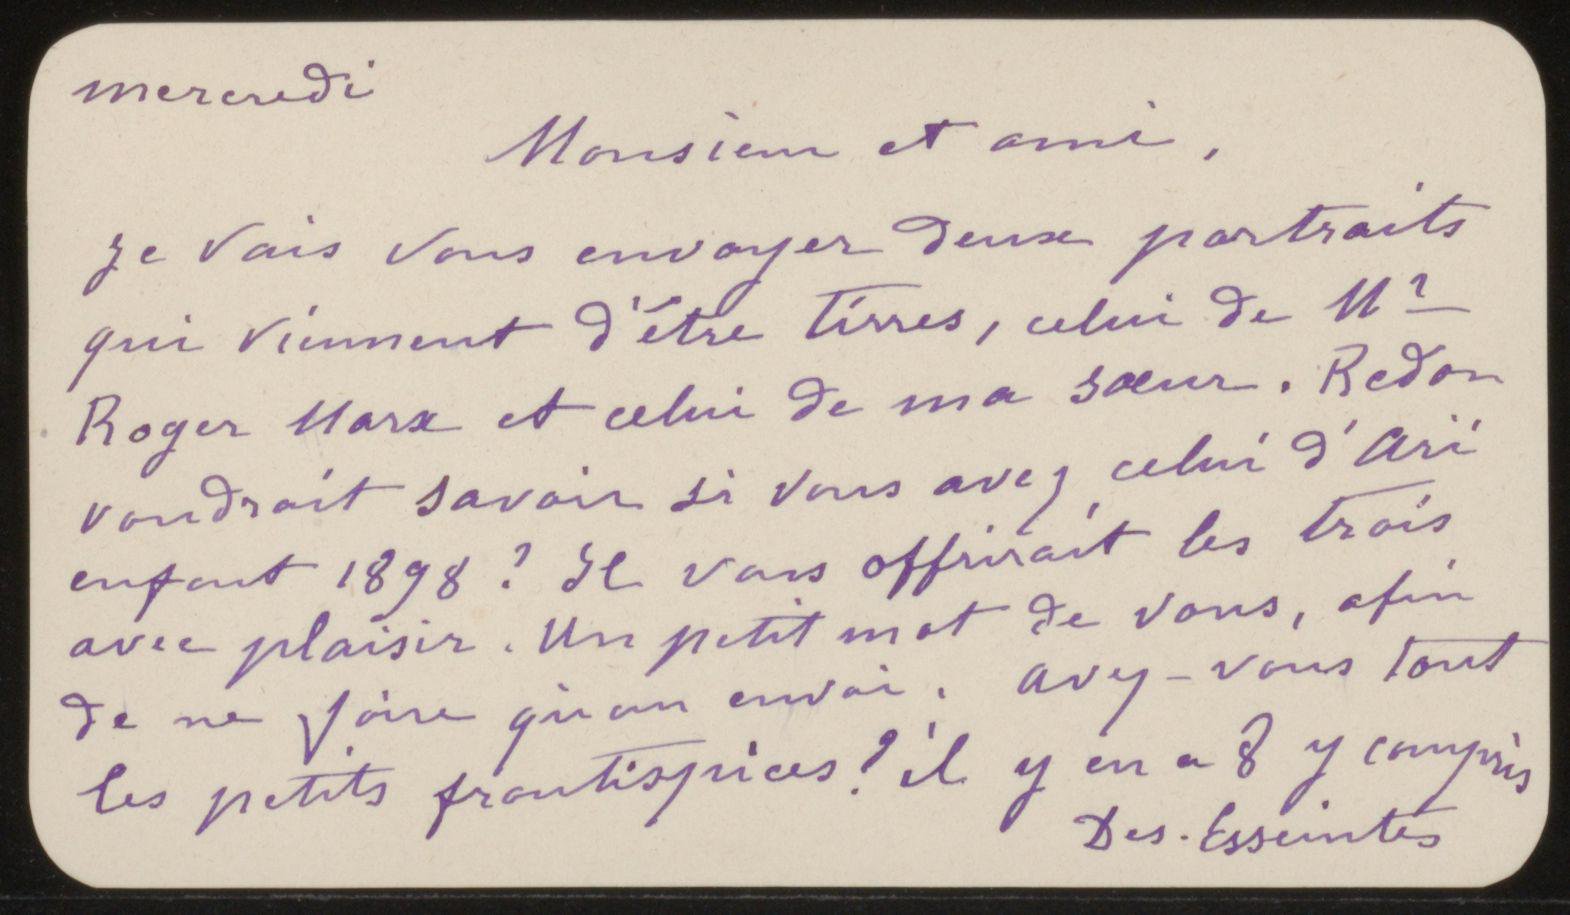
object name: letter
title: Brief aan Andries Bonger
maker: camille redon-falte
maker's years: 1853-1923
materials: ink, paper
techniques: pen, writing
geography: paris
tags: arï redon, armand clavaud, painter, print maker, draughtsman, odilon redon, amsterdam, andries bonger, paris, roger marx, edgar allan poe, historical persons (portraits and scenes from the life), money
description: Brief behoort tot een album samengesteld door weduwe Françoise W.M. Barones van der Borch van Verwolde met afschriften van brieven met betrekking tot (de familie van) Odilon Redon. De brief werd bewaard op pagina 146.